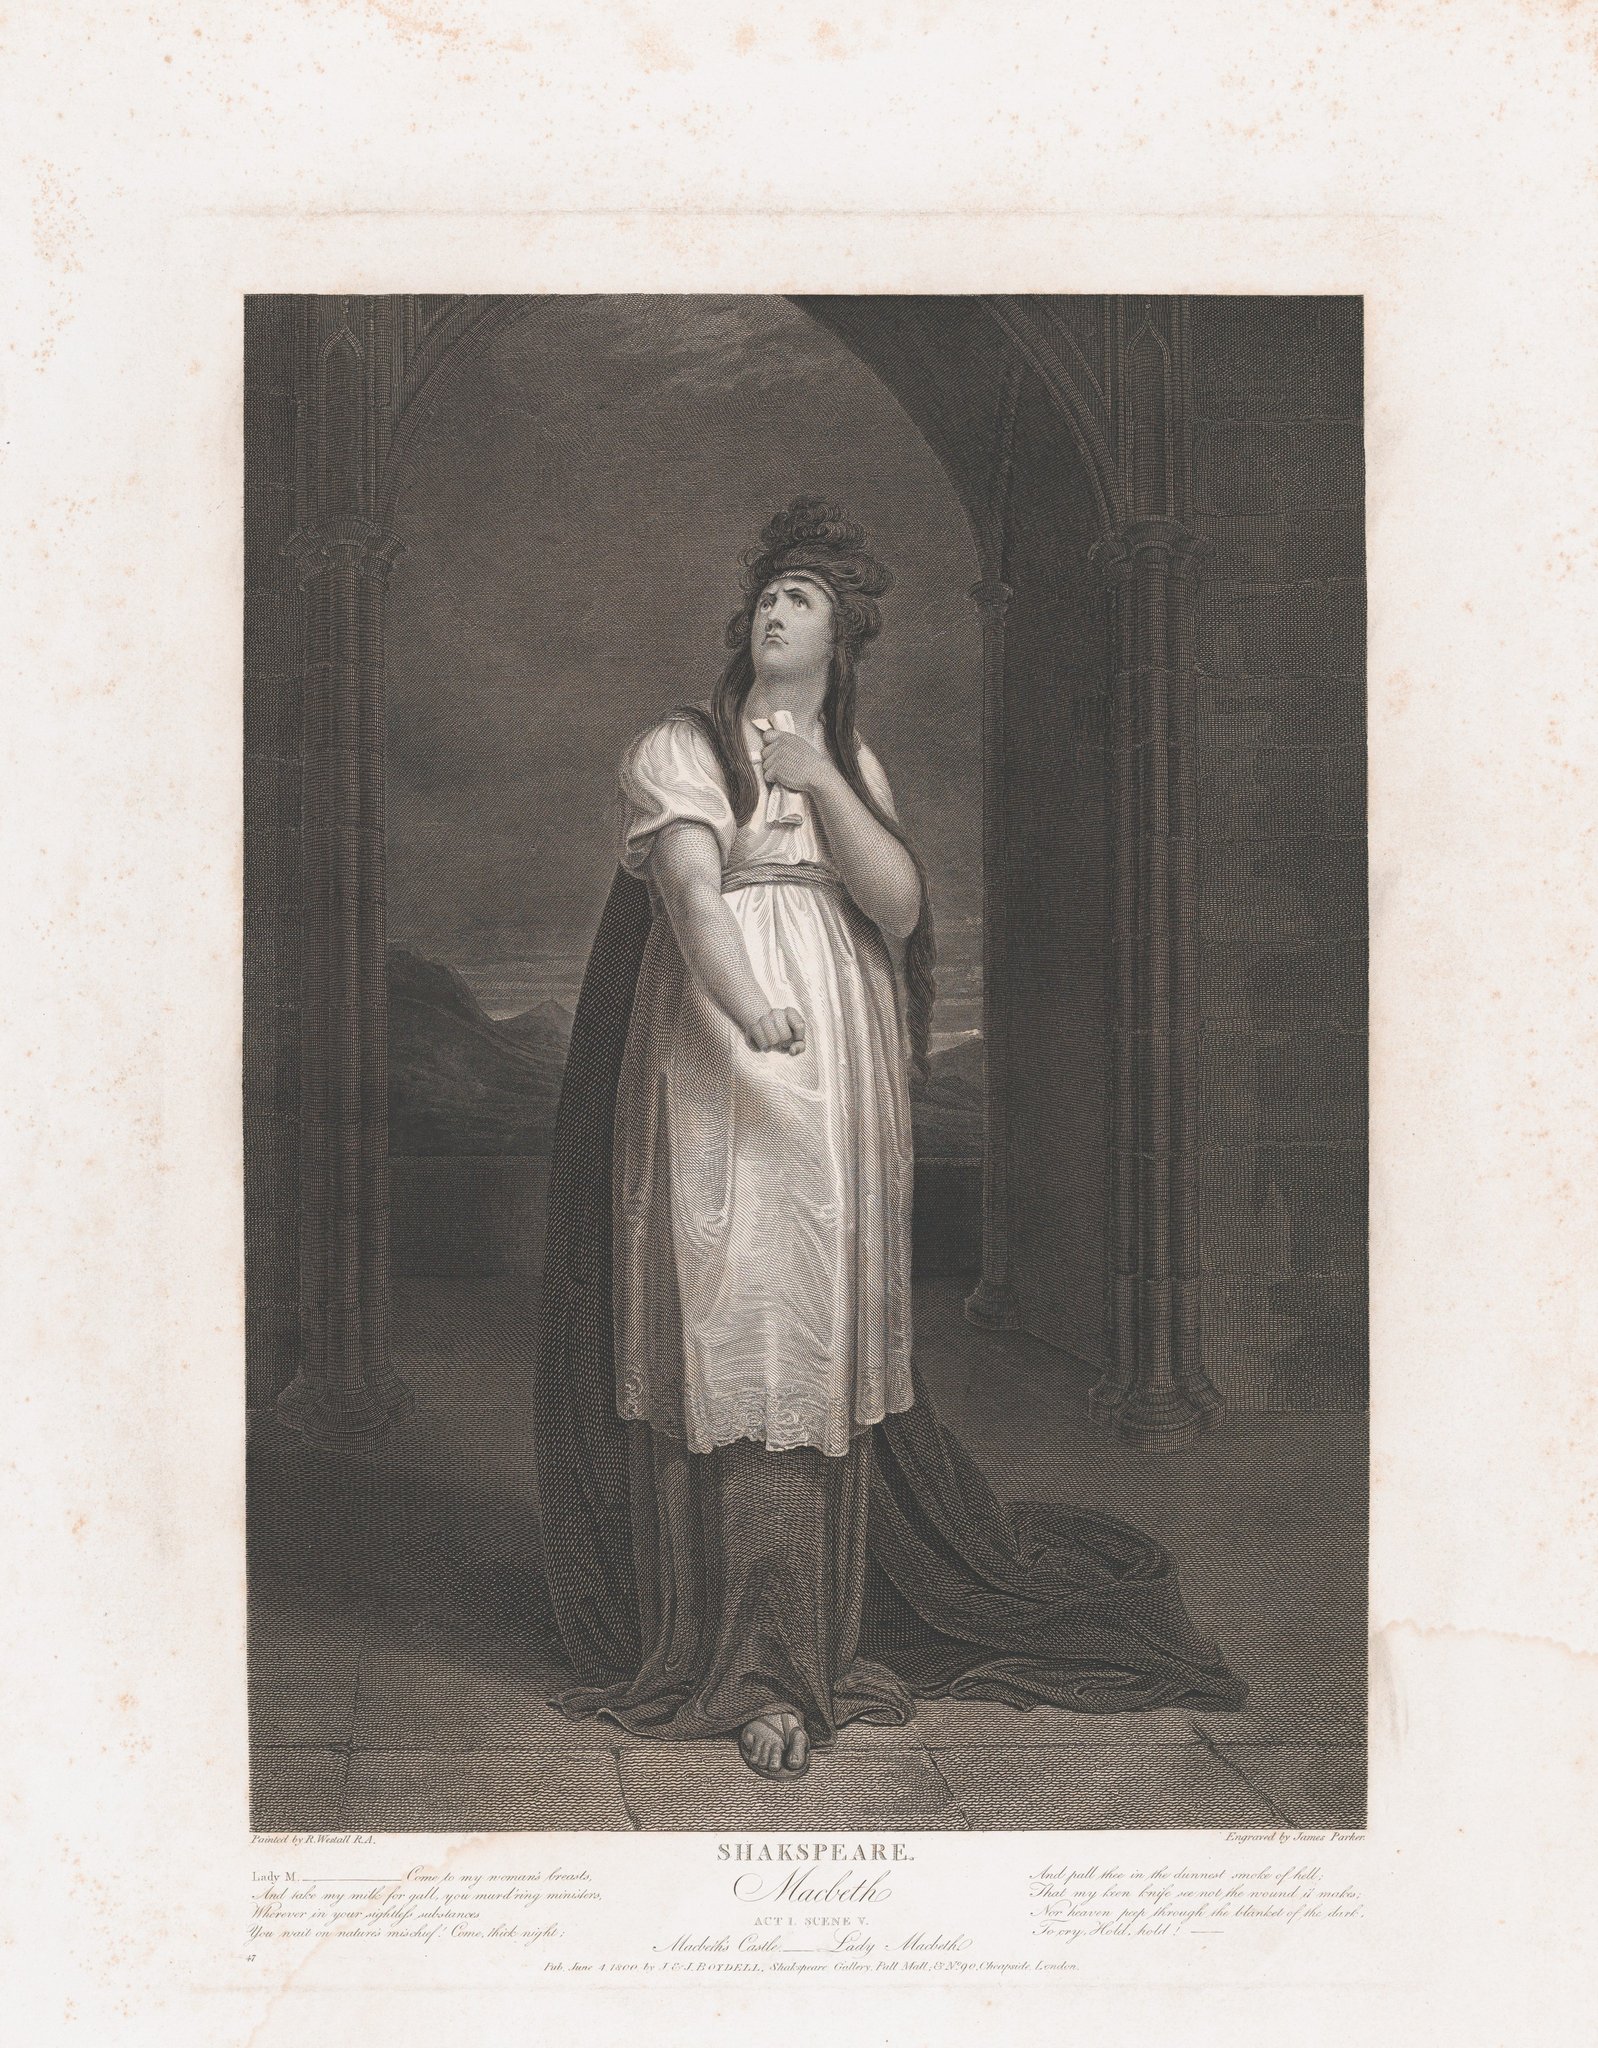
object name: print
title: Lady Macbeth (Shakespeare, Macbeth, Act 1, Scene 5)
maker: james parker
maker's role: engraver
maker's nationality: british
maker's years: 1750-1805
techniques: engraving, etching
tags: shakespeare,women,macbeth